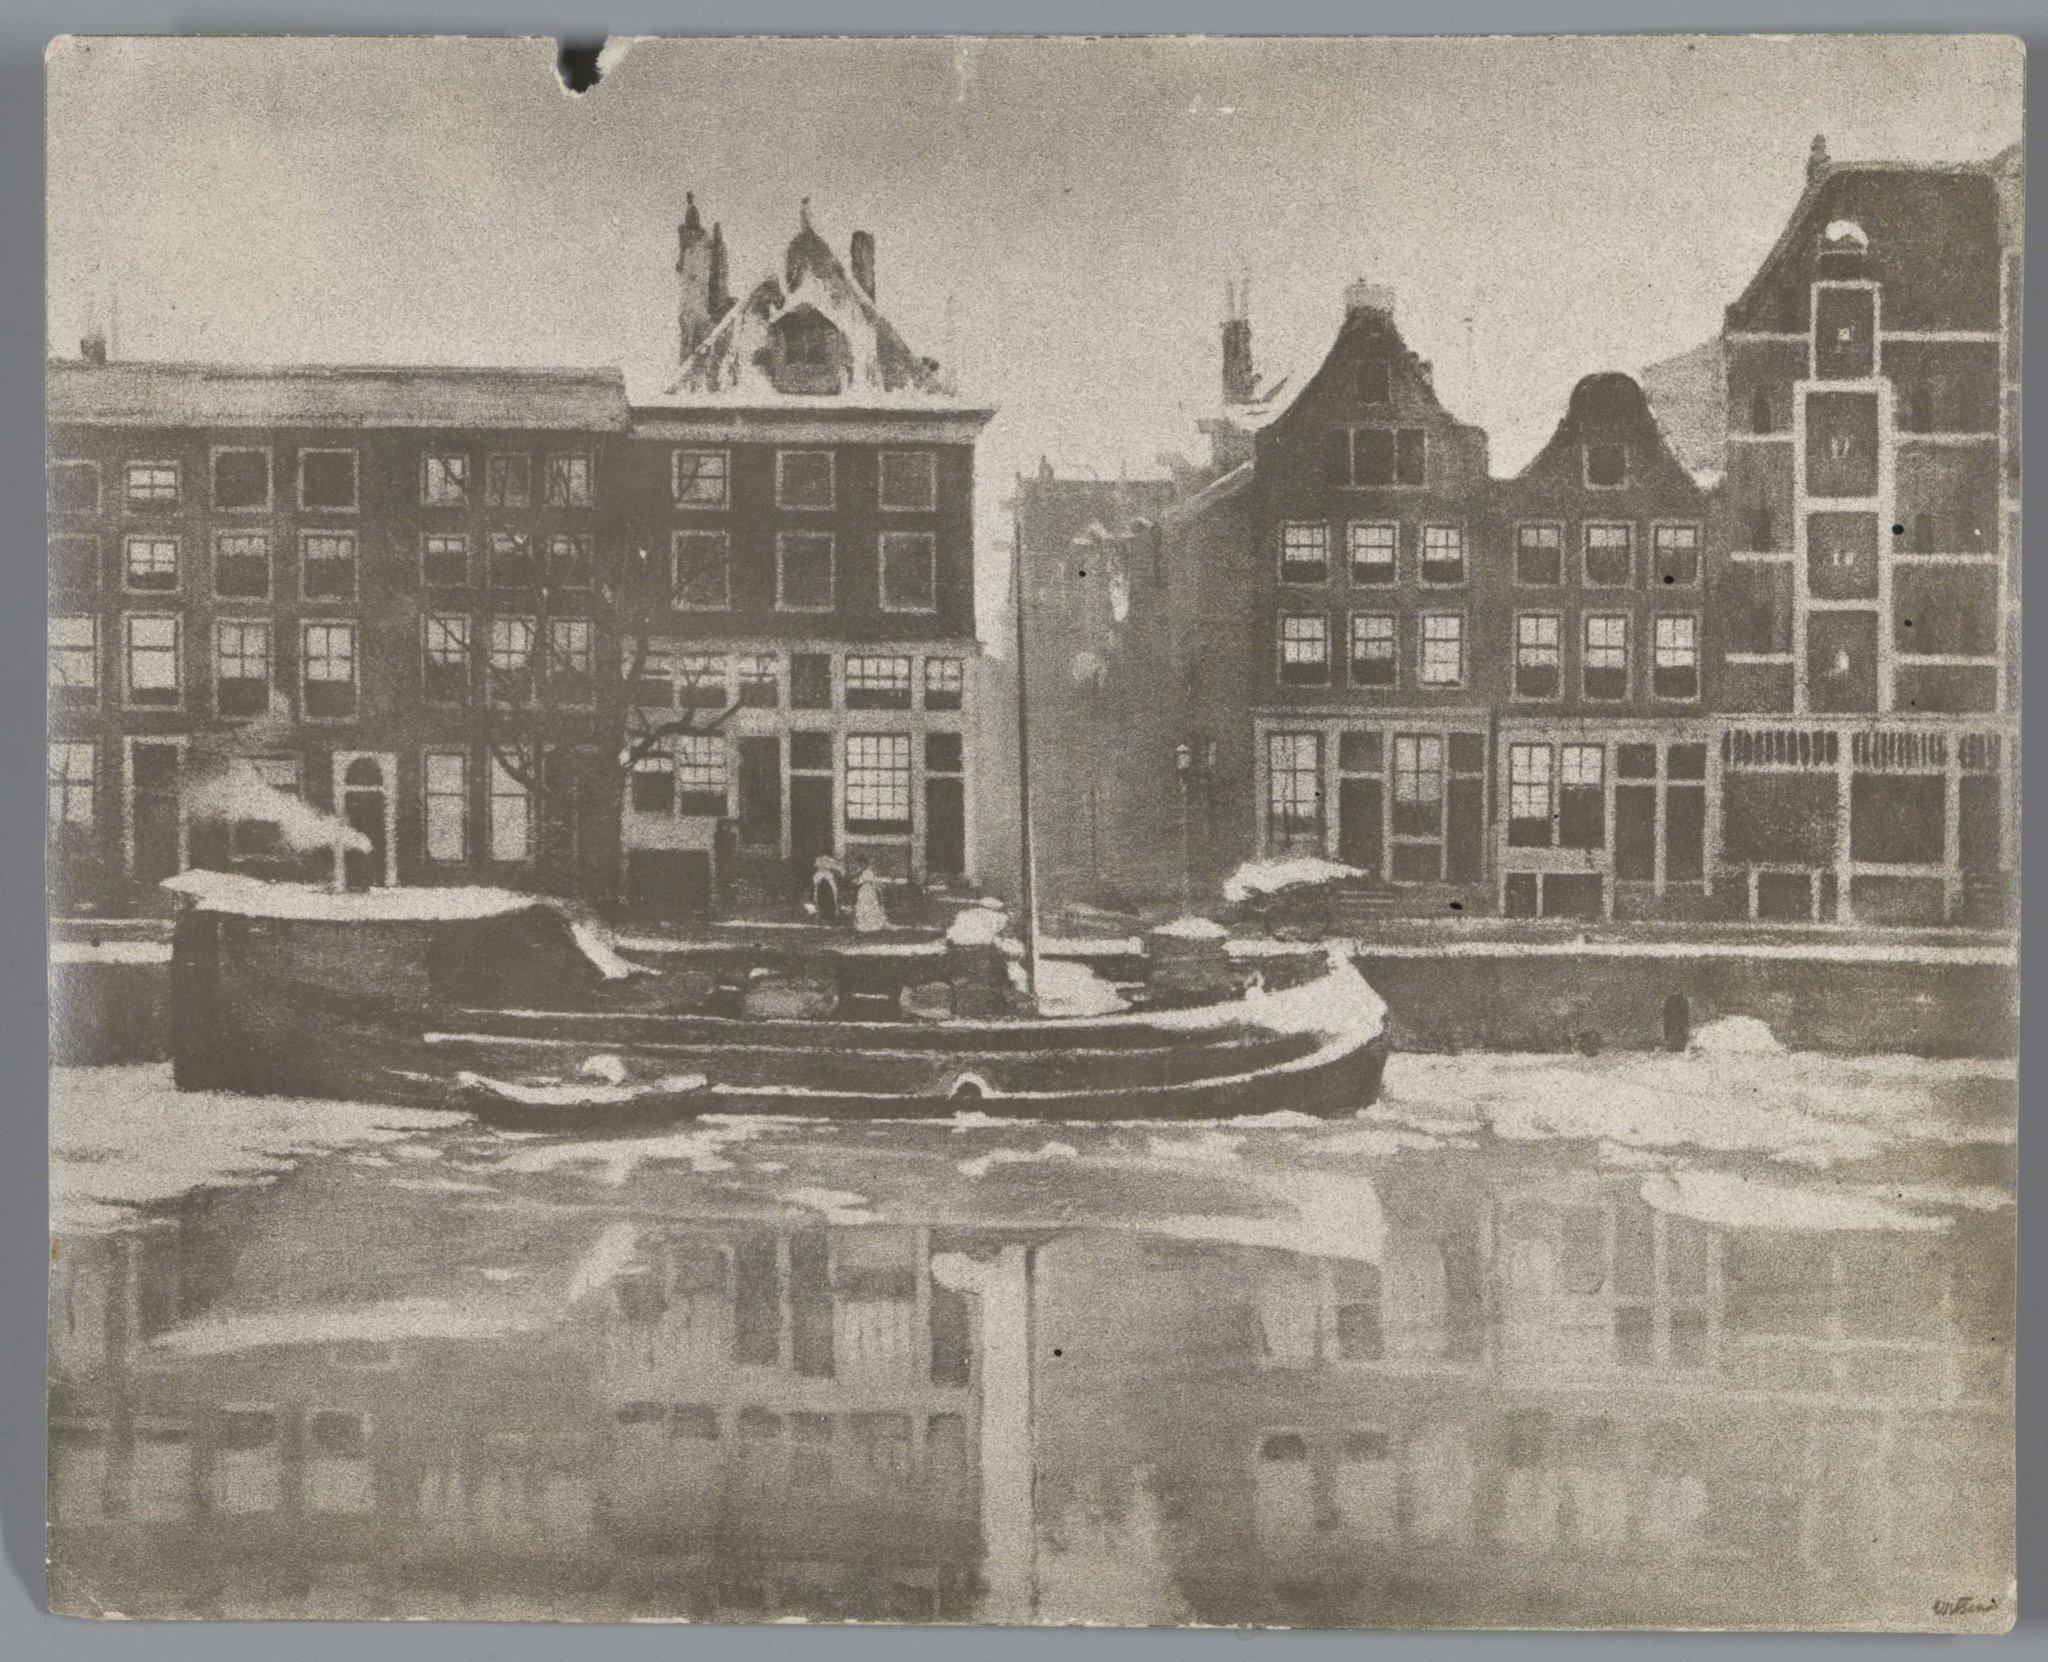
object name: photograph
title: Reproductie naar een foto, schilderij, tekening of prent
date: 1860-1915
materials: paper, photographic support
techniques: gelatin silver print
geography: netherlands